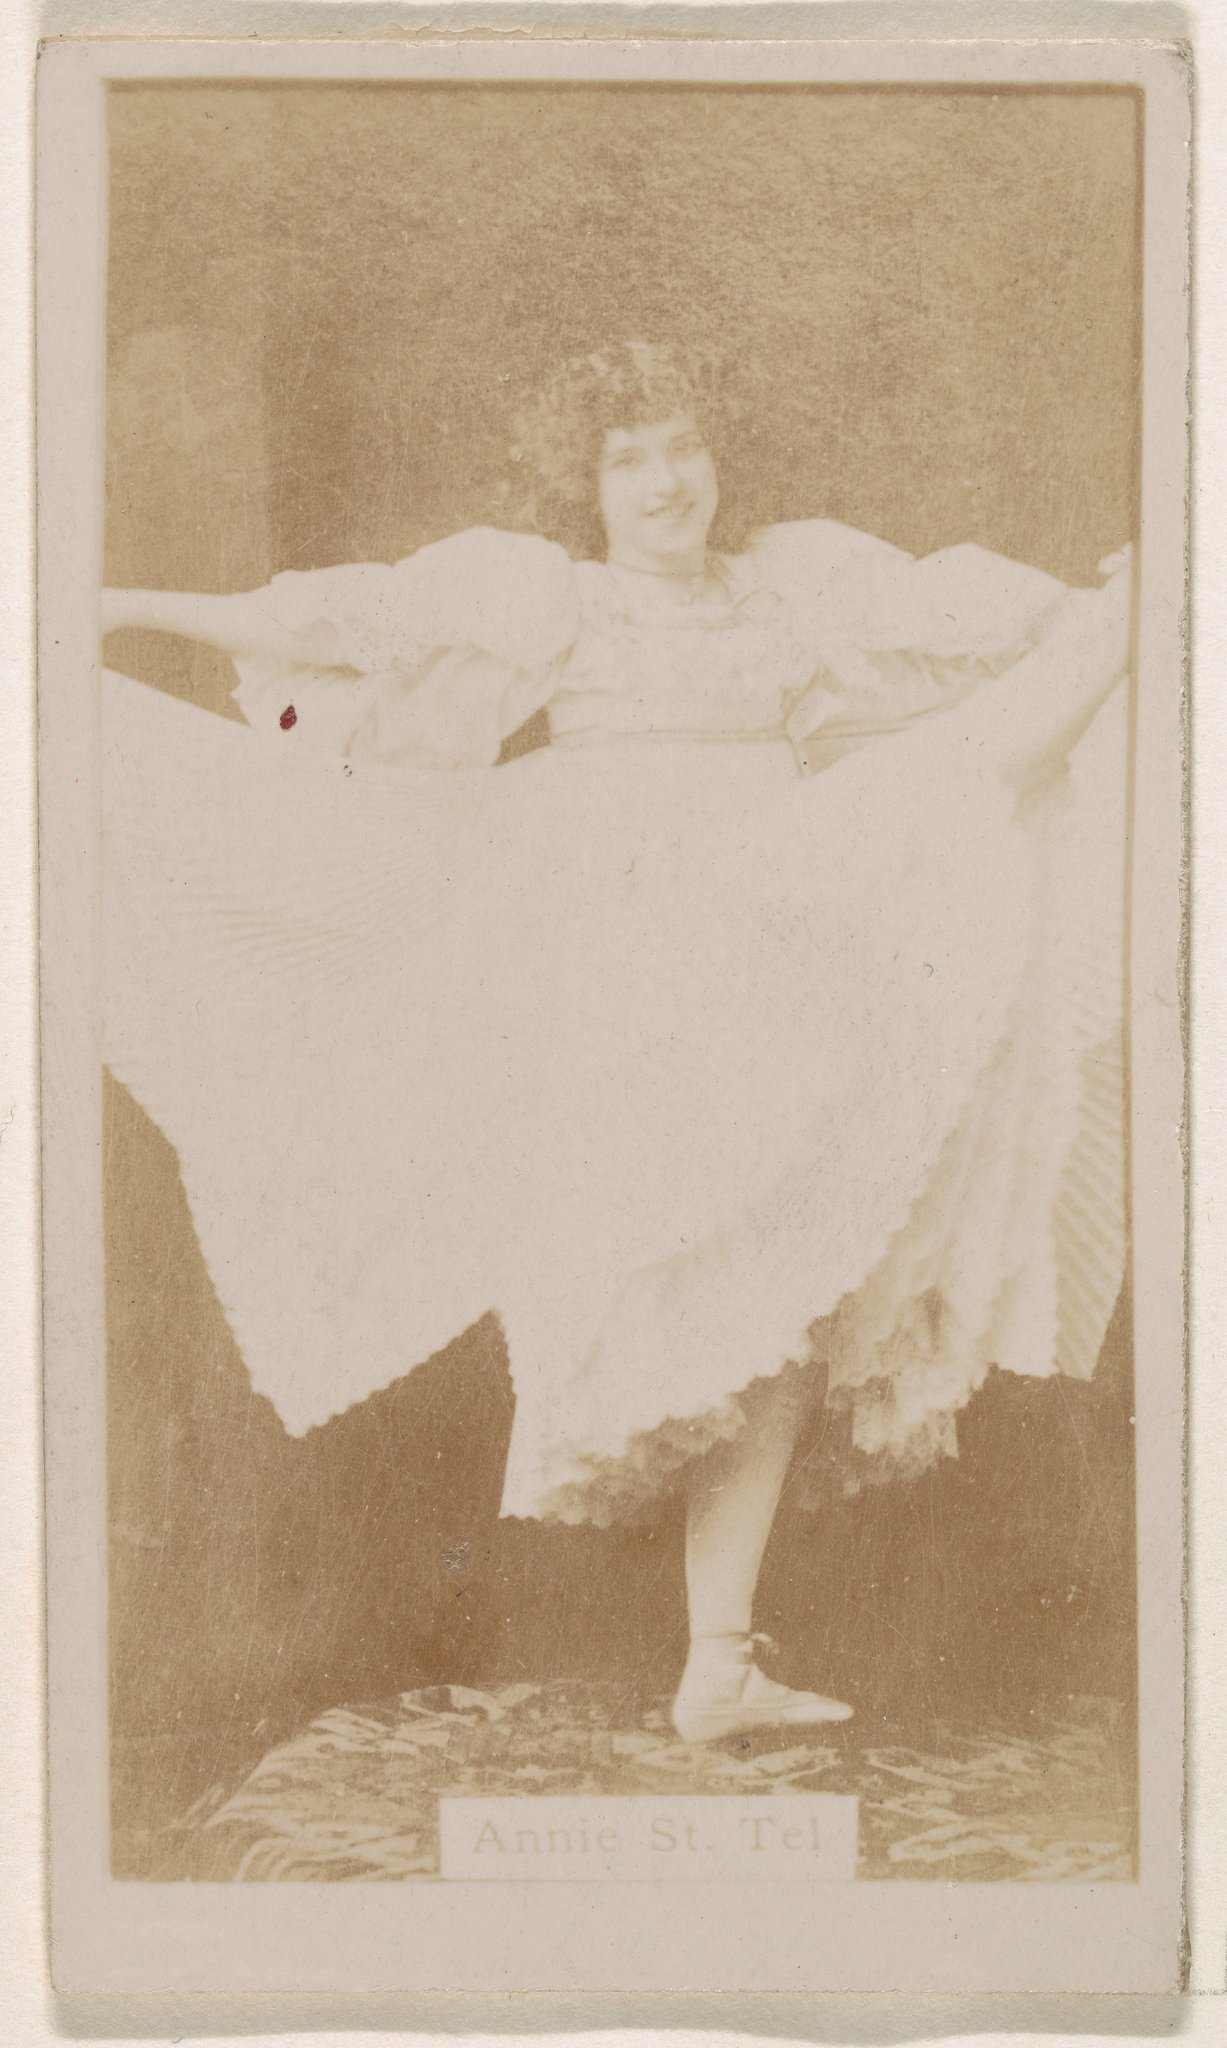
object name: photograph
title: Annie St. Tel, from the Actresses series (N245) issued by Kinney Brothers to promote Sweet Caporal Cigarettes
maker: kinney brothers tobacco company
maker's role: publisher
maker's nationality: american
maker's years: 1869-2011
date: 1890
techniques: albumen silver print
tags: portraits,women,actresses